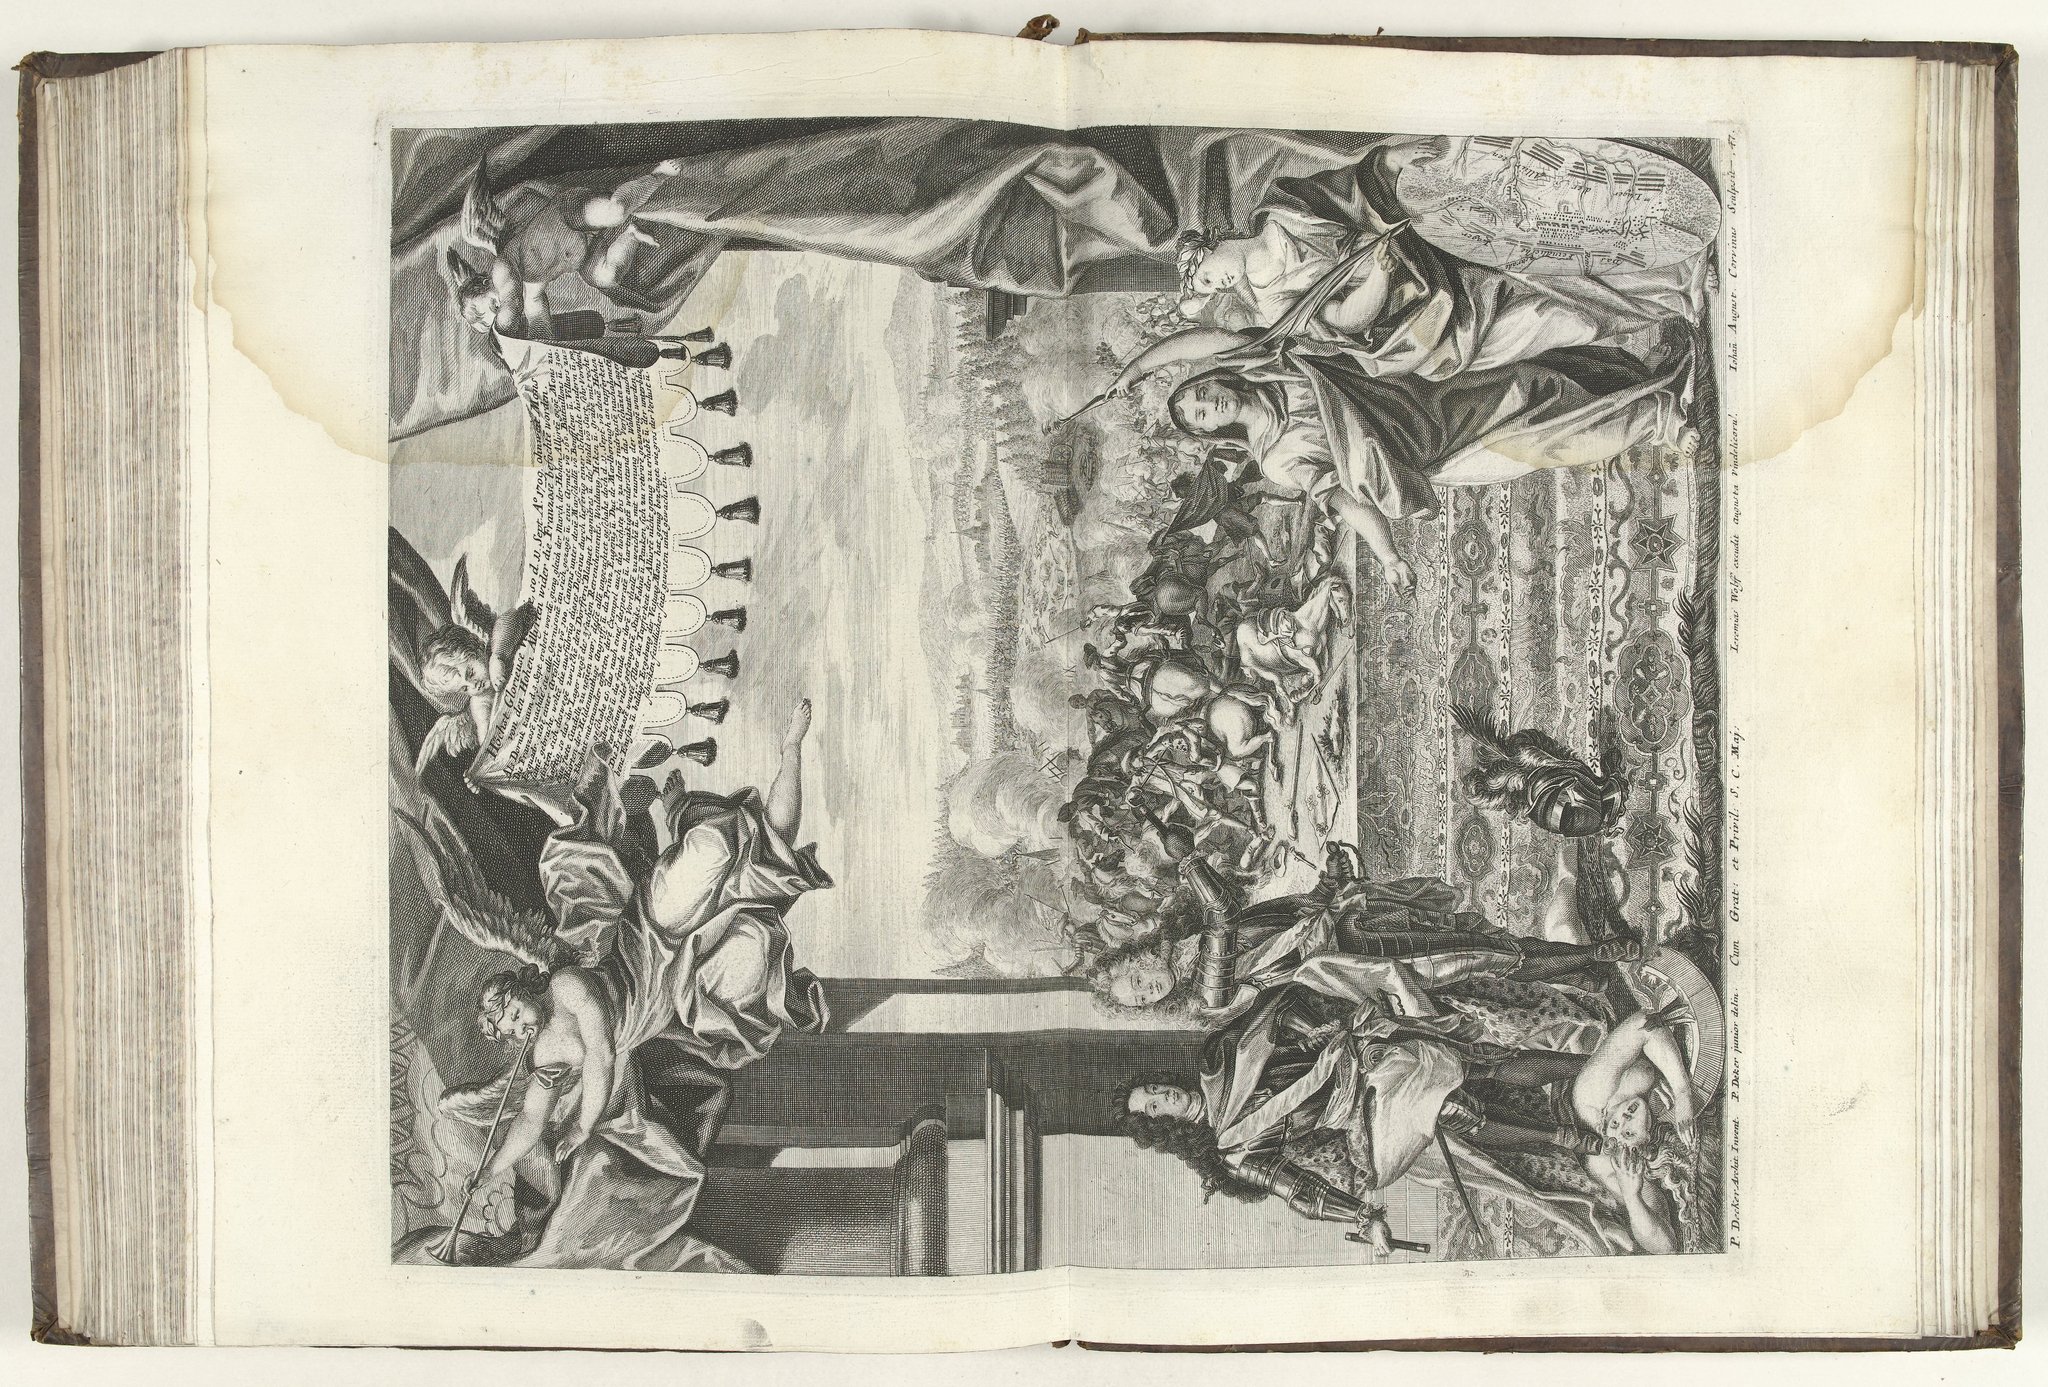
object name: history print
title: Höchst Glorieuse Victorie, so d. 11. Sept. Ao. 1709 ohnweit Mons von den Hohen Allyrten wider die Franzose. befochte. worden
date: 1712-1715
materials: paper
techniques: engraving, etching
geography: augsburg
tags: paris, eugenius van savoye, john churchill (1e hertog van marlborough), battle (+ land forces)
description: De slag bij Malplaquet (bij Mons) waarbij de Geallieerden onder de hertog van Marlborough en de prins van Savoye een overwinning behalen op de Fransen, 11 september 1709. Centraal de veldslag, op de voorgrond links de hertog van Marlborough en de prins van Savoye, rechts twee allegorische figuren. Bovenaan de Faam bij een draperie met de beschrijving van de gebeurtenissen in het Duits. Blad in de gebonden verzameling platen uitgebracht onder de titel: Repraesentatio belli ... Der Spanische Successions-Krieg [ca. 1720].